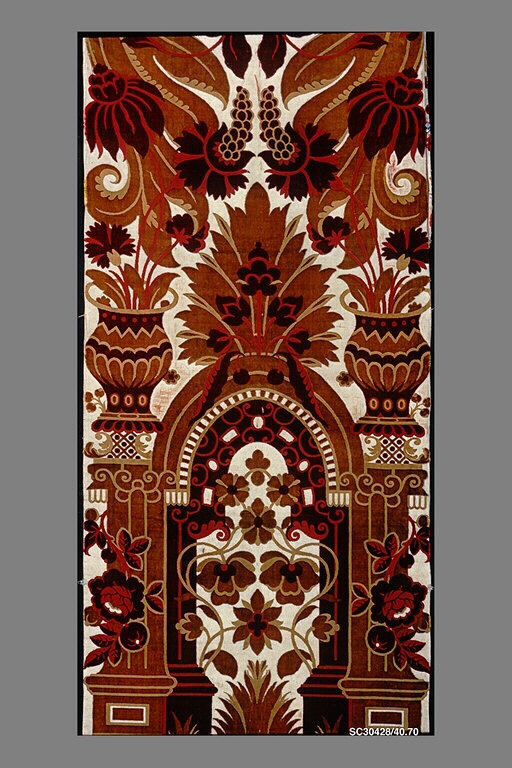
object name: piece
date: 1715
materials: silk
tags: arches,columns,flowers